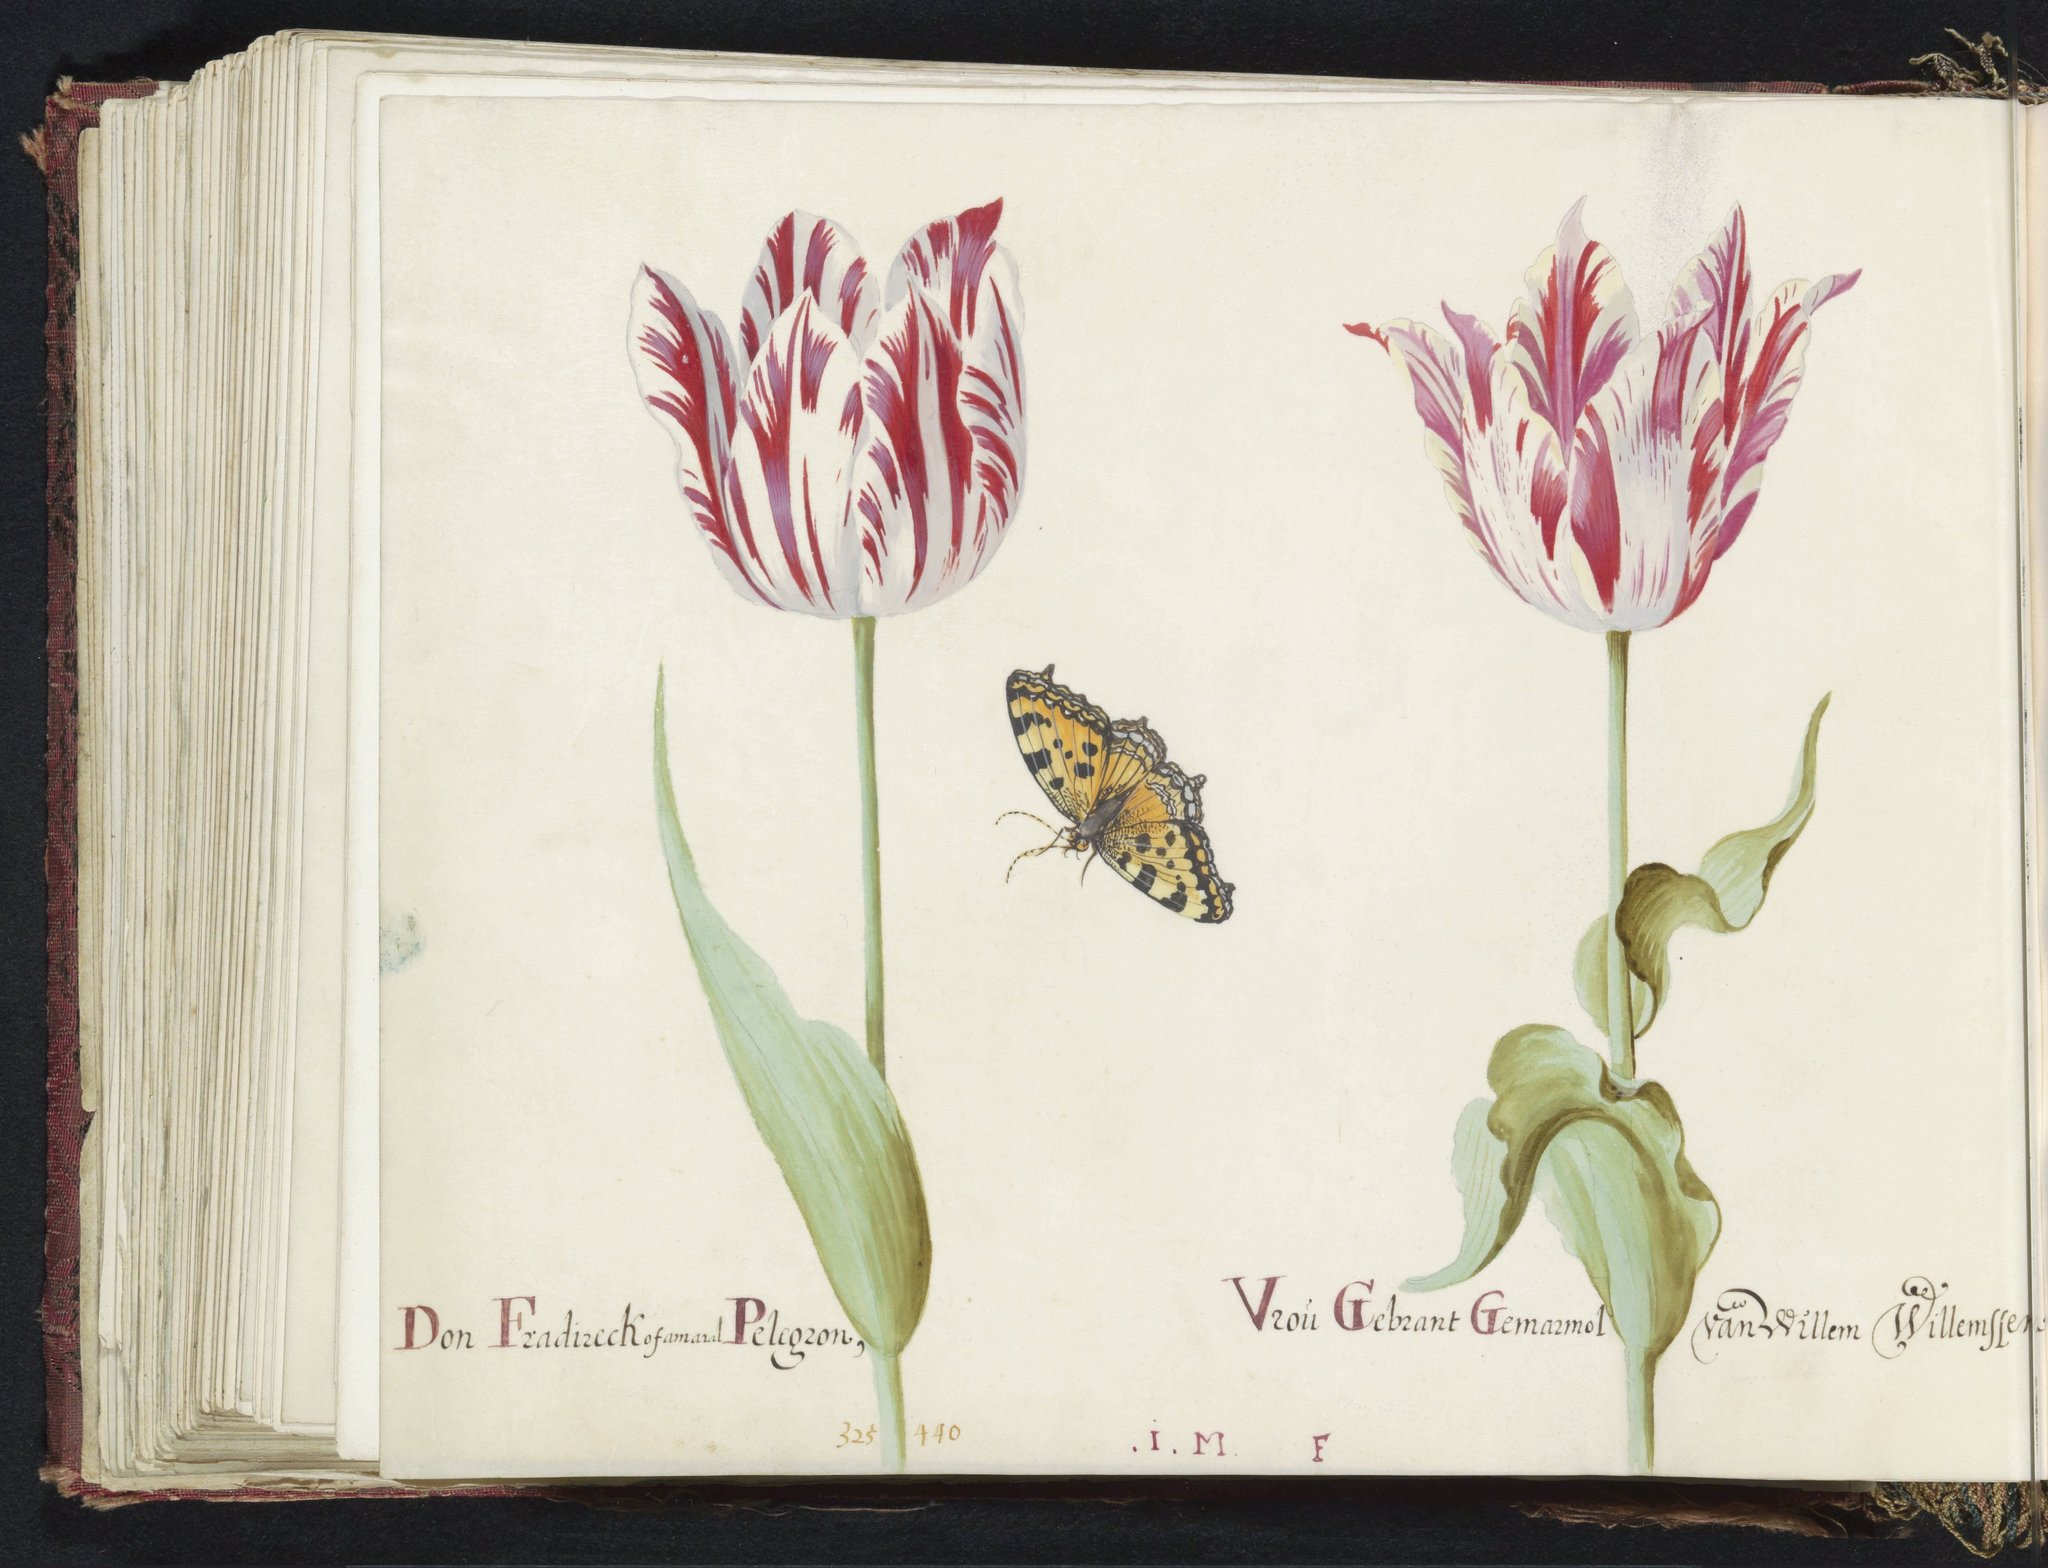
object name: drawing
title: Twee tulpen met kleine vos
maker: jacob marrel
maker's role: draughtsman, painter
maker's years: 1614-1681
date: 1637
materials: paint, parchment, pencil, watercolor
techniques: brush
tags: insects: butterfly, flowers: tulip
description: De tekening maakt deel uit van een album.